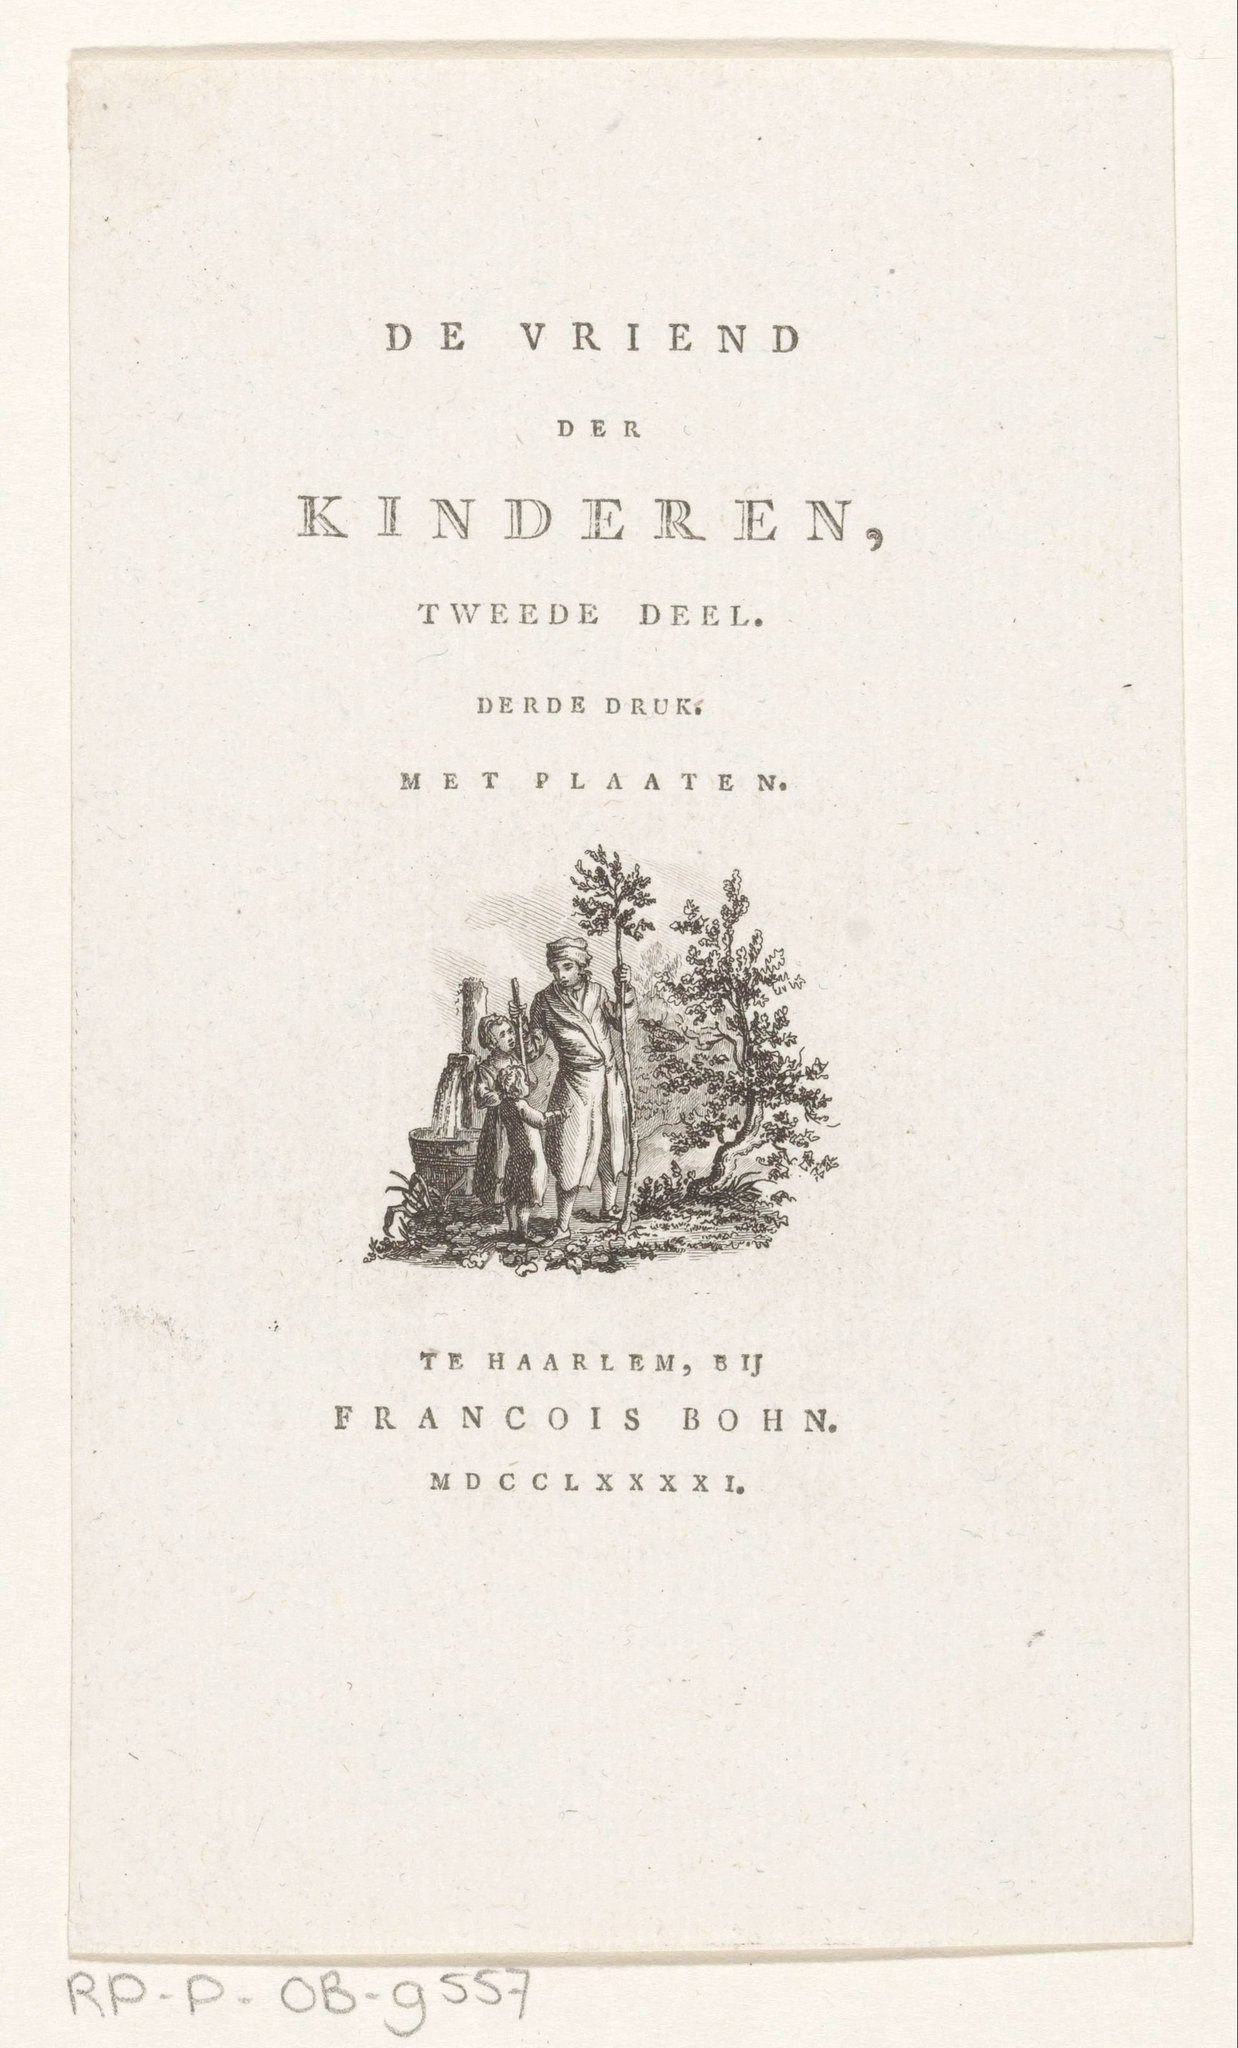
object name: titelblad, titelpagina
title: Allegorie op tuinbouw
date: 1791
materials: paper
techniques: engraving, etching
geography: haarlem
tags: gardening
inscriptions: collector's mark: Lugt 2228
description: Titelpagina voor: S.n. De vriend der kinderen, tweede deel. Haarlem: Bohn, François, 1791.